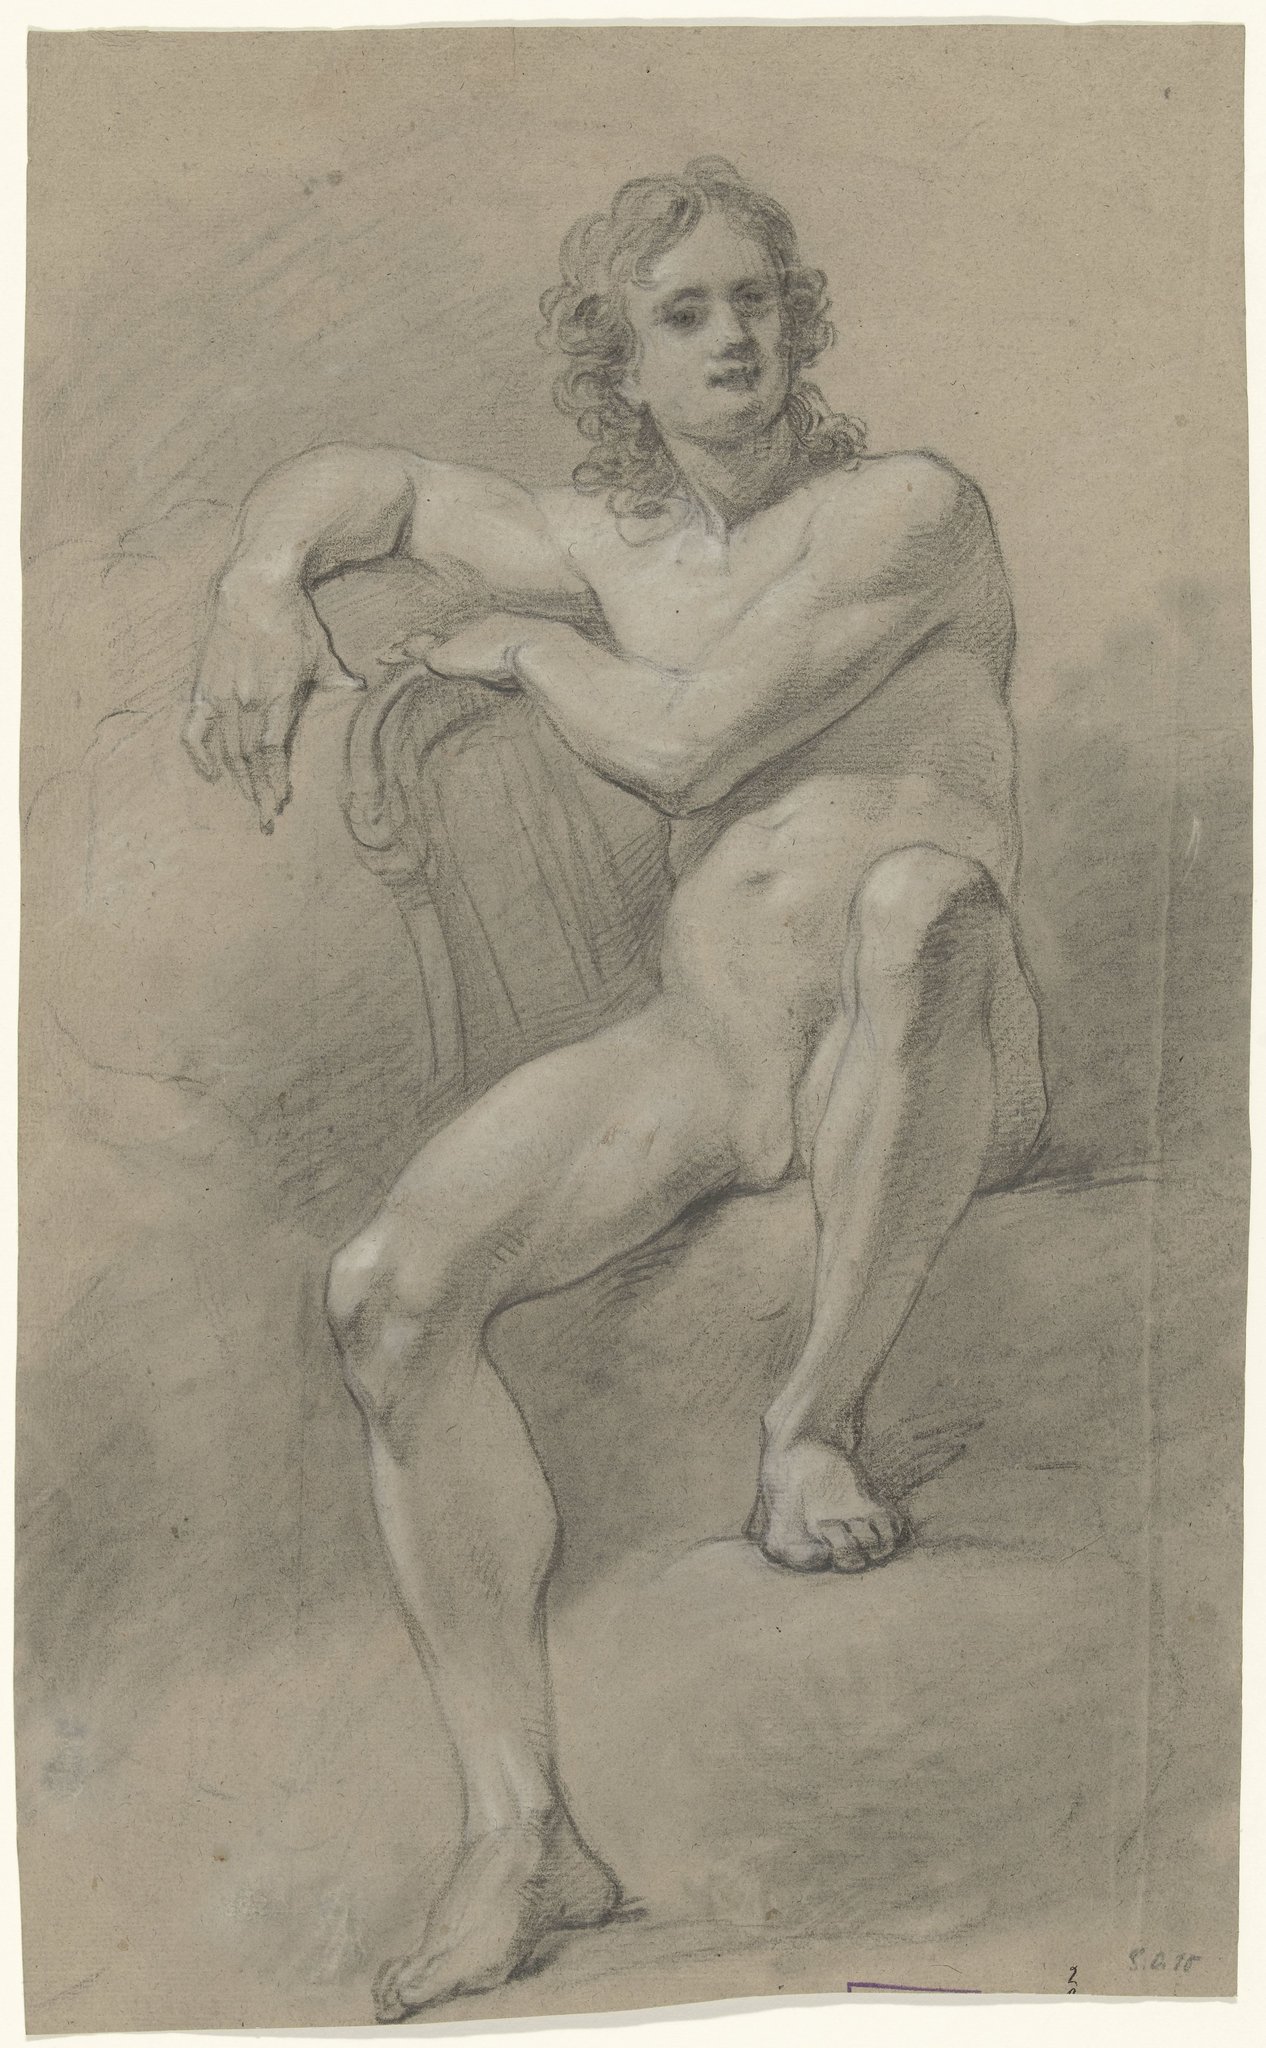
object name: drawing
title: Zittend mannelijk naakt, met harp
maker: Anonymous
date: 1700-1800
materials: chalk, paper